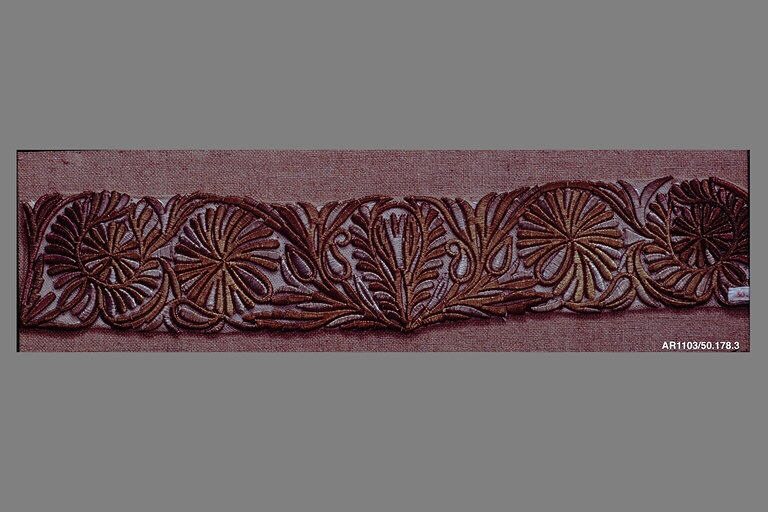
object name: piece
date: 1801-1900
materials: metal thread